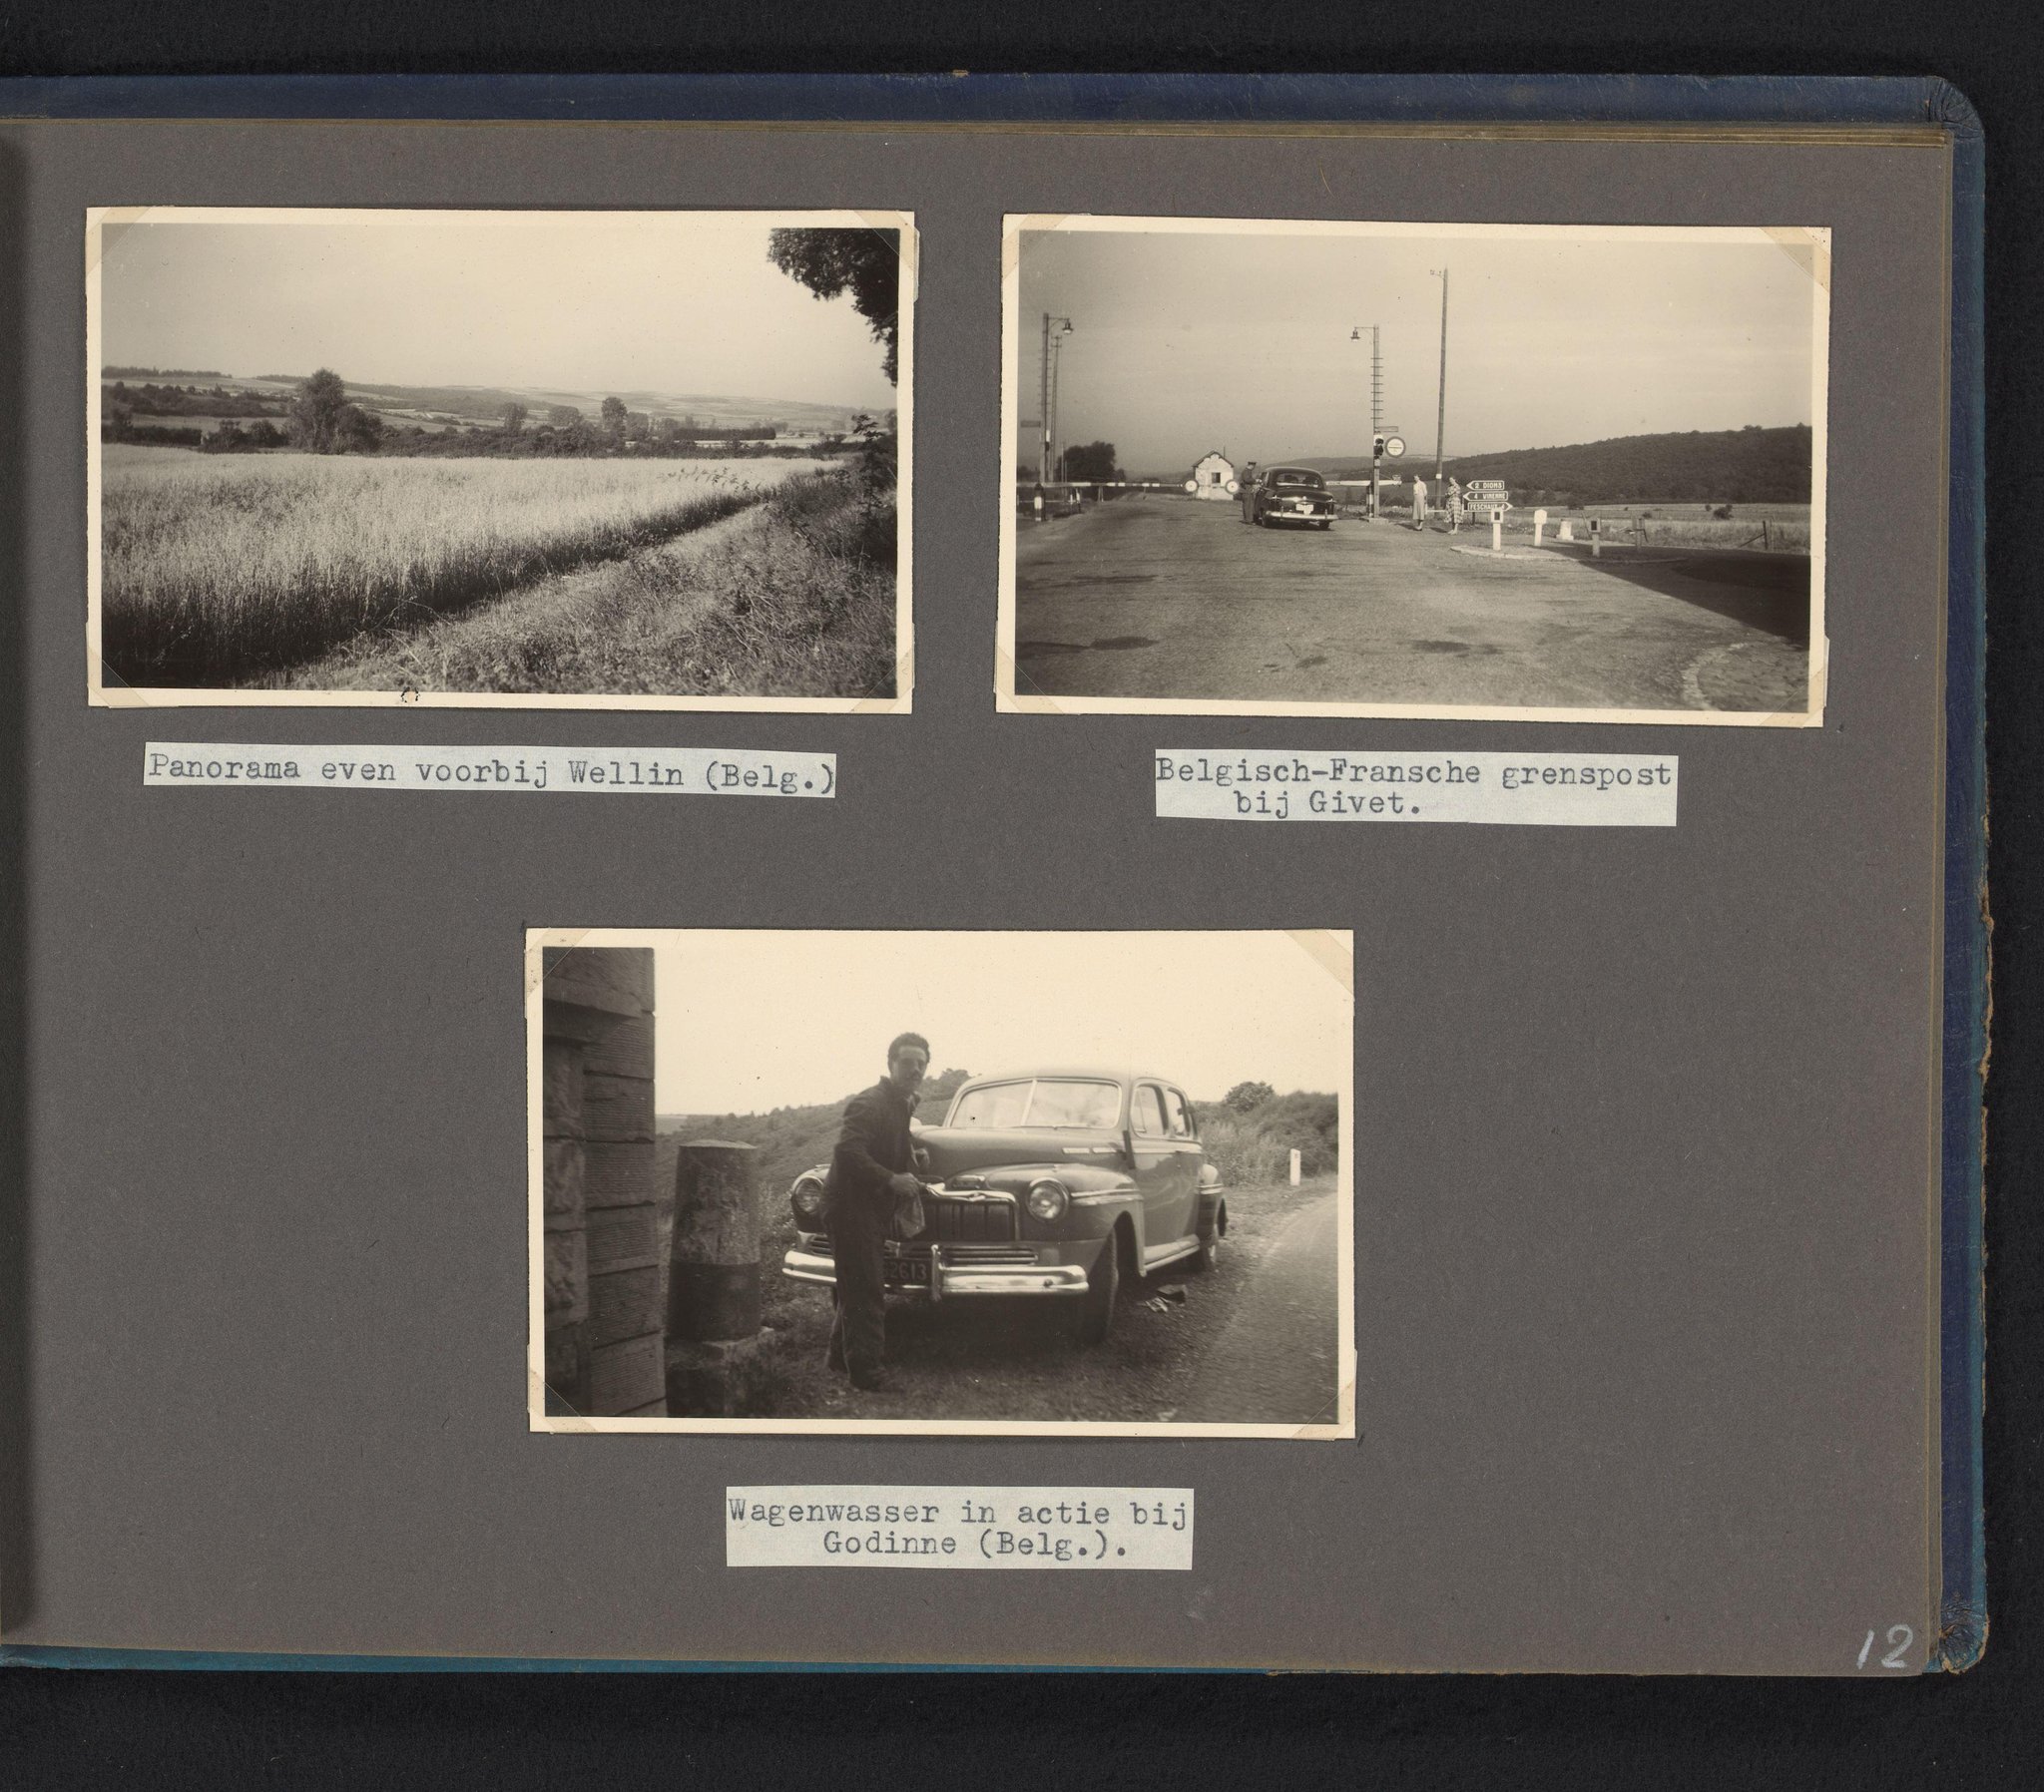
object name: photograph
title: Wellin, Givet en Godinne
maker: Anonymous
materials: paper, photographic support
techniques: gelatin silver print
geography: belgium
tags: the family travelling, on holiday, customs, outing, pleasure trip, automobile, belgium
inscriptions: inscription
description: Albumblad met drie foto's van een autovakantie. Gezichten onderweg in België. Onder de foto's uitgeknipte papiertjes met getypte opschriften. Onderdeel van het derde fotoalbum met foto's van familievakanties in Nederland, België en Luxemburg in 1952-1953.